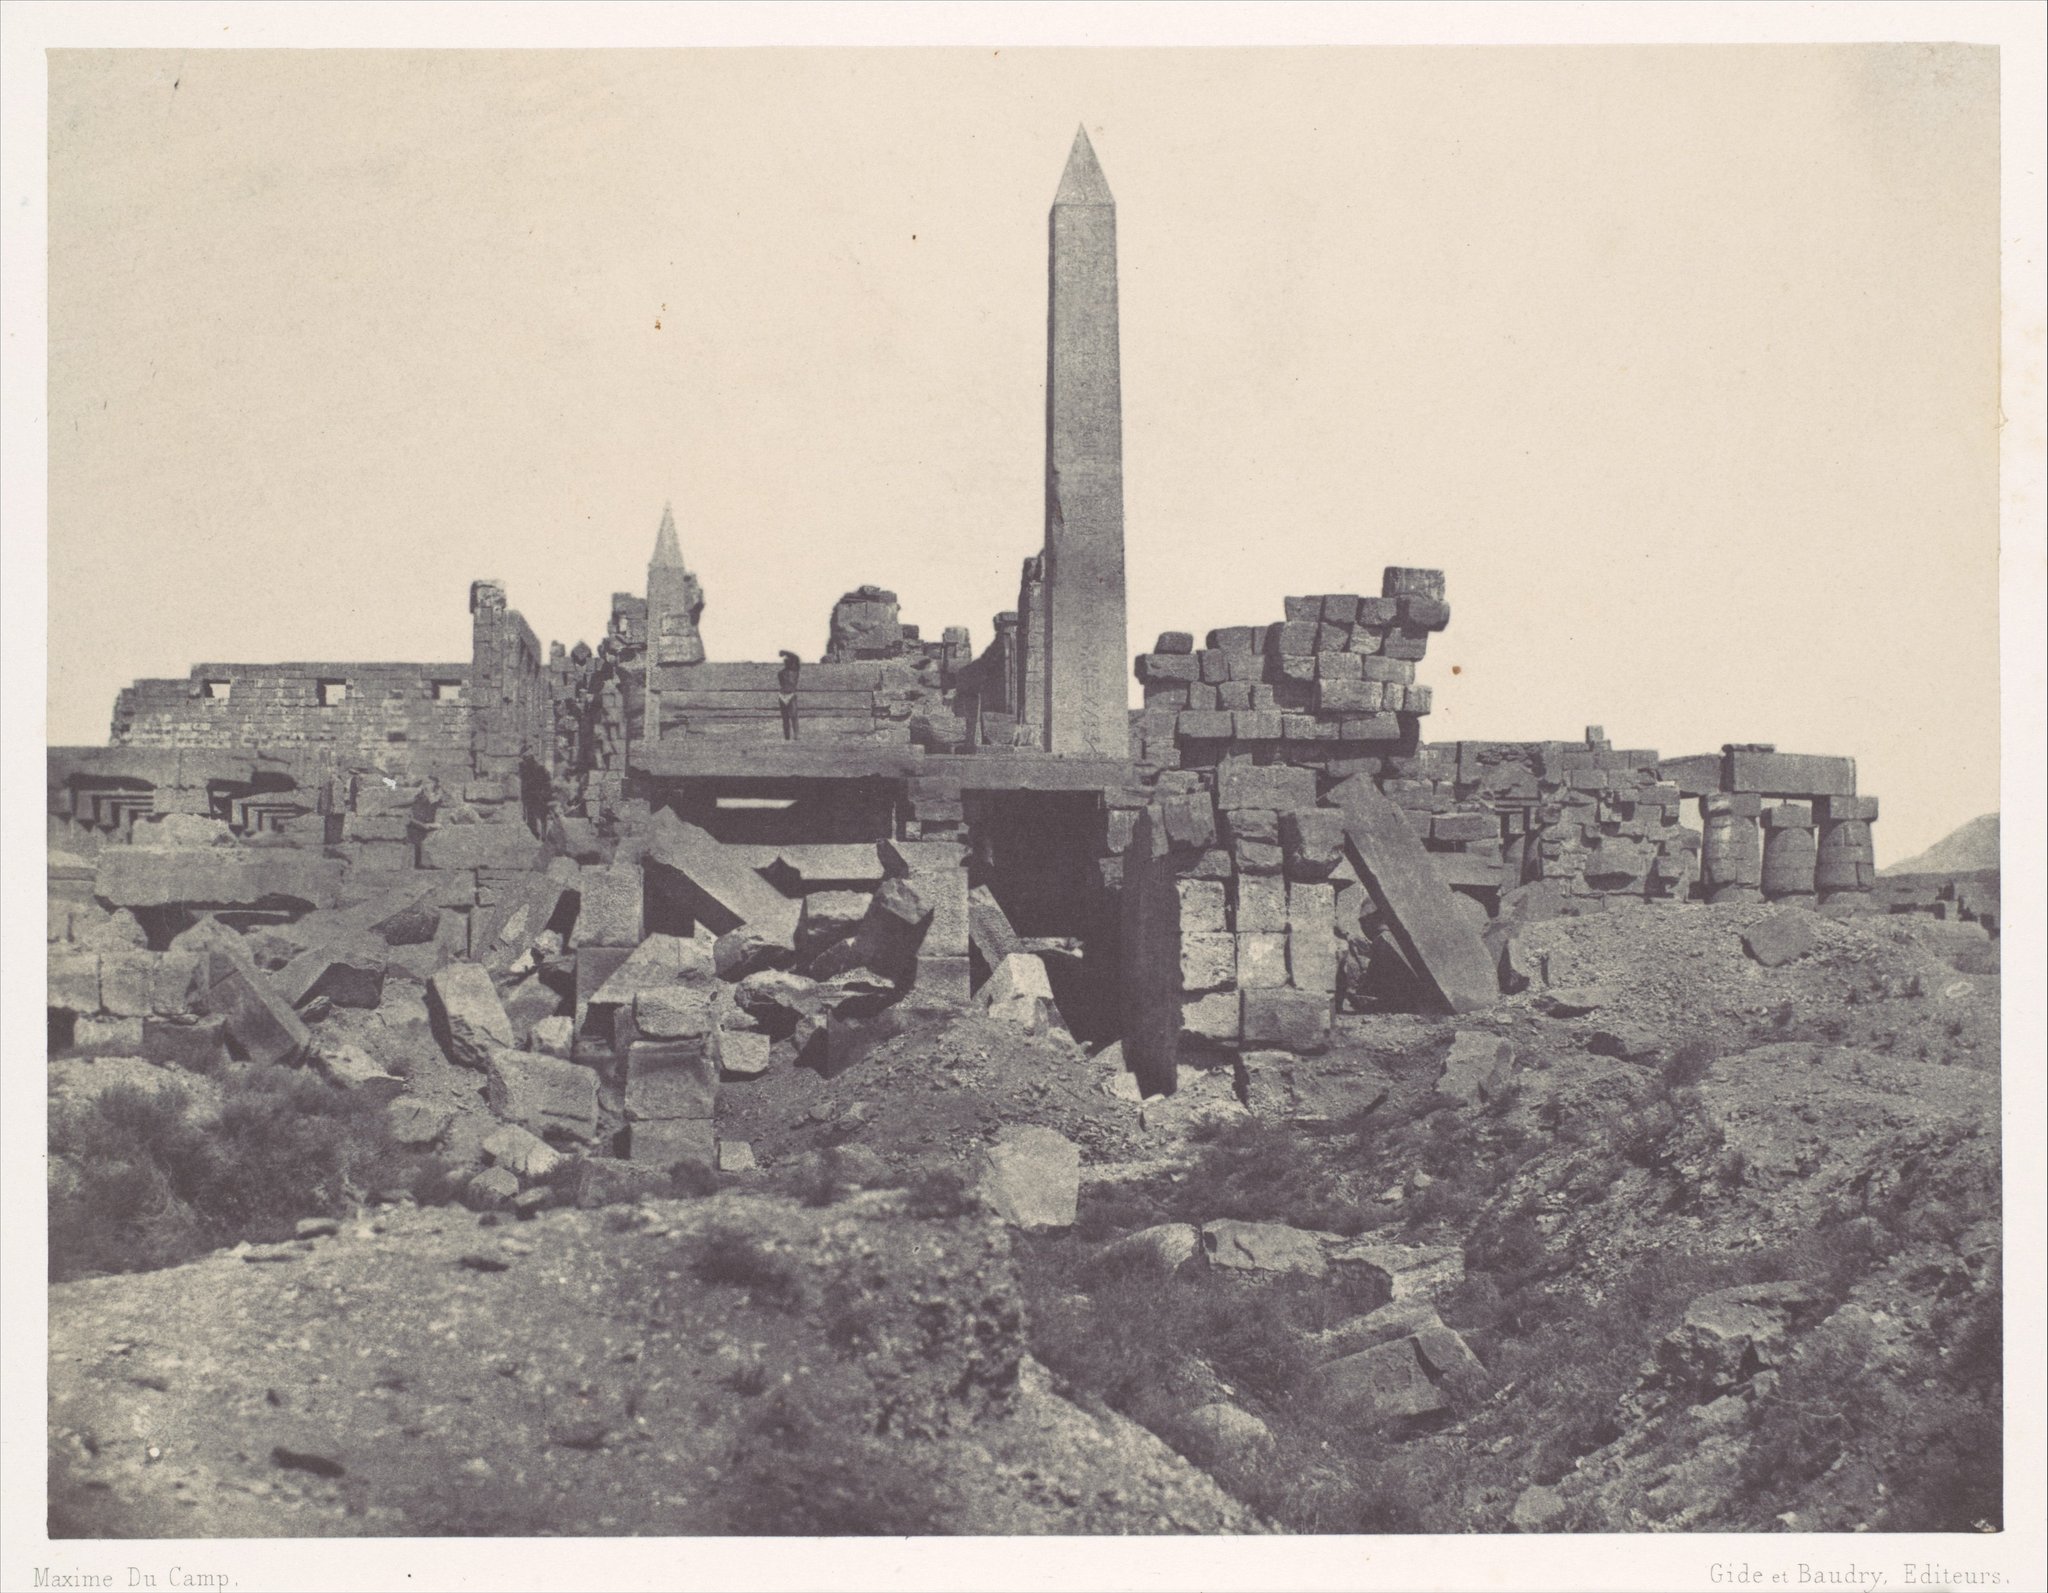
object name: photograph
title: Thebes. Palais de Karnak. Sanctuaire de granit et salle Hypostyle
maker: maxime du camp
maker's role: artist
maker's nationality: french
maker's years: 1822-1894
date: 1850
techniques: paper negative, salted paper print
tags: obelisks,ruins